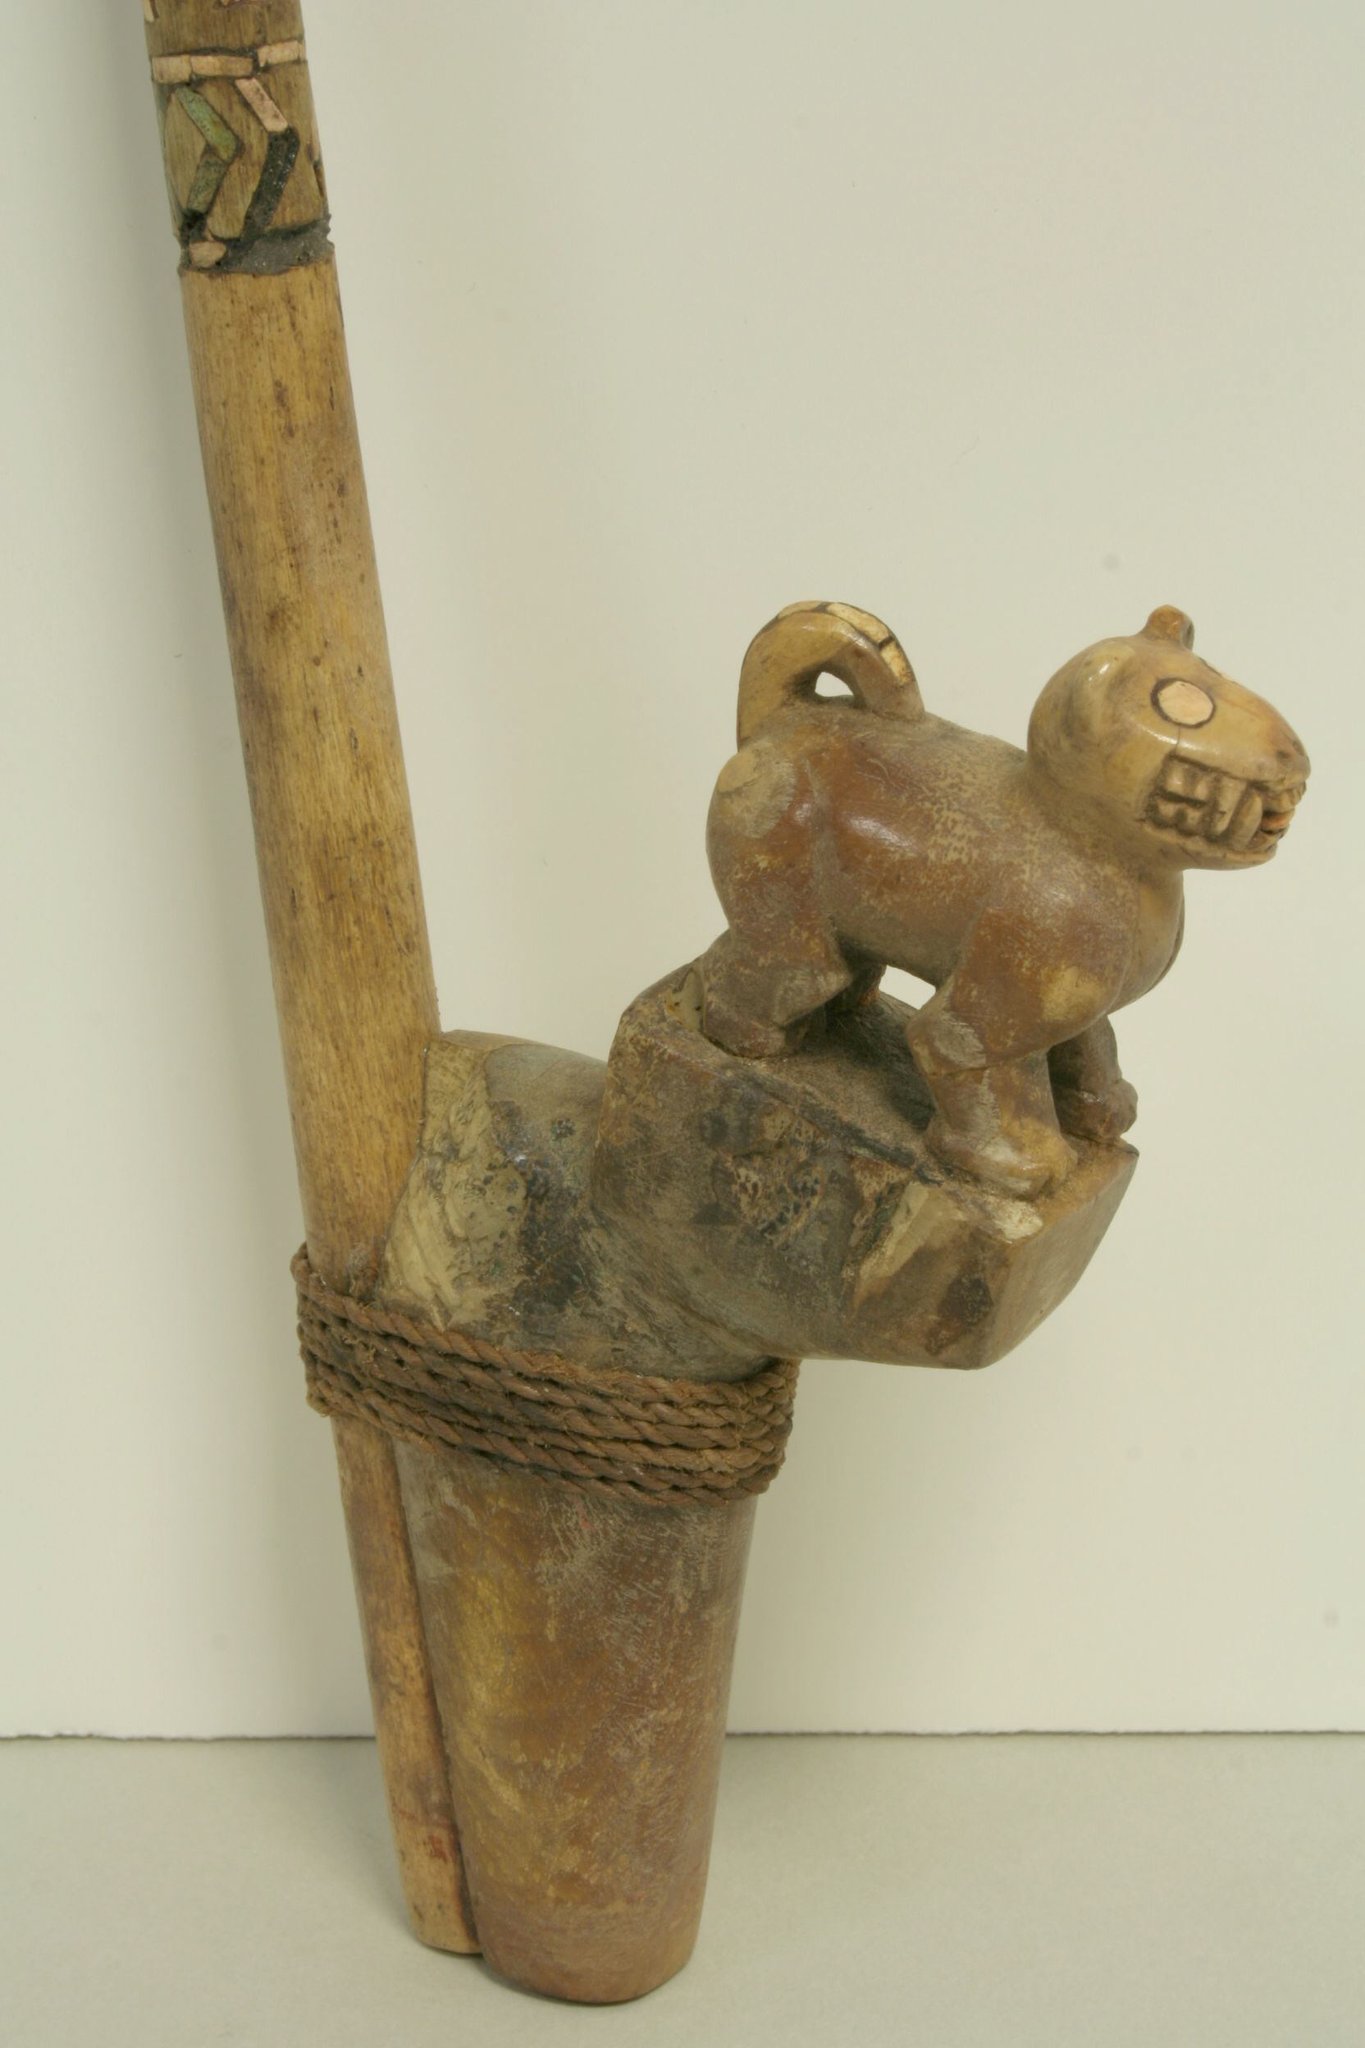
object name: spear thrower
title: Spear Thrower with Feline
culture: moche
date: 100 BCE-700 CE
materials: bone, shell, stone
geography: peru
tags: cats